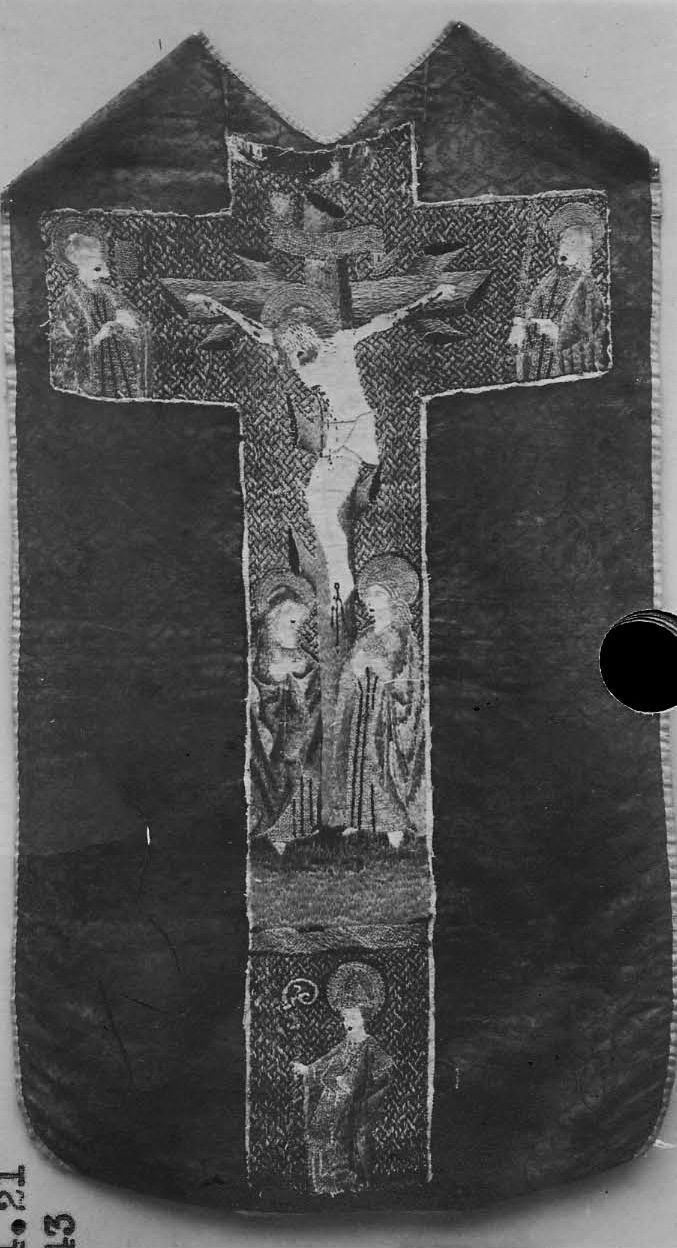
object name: chasuble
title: Chasuble with The Crucifixion, Holy Women and Saints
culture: german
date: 1601-1633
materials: silk, thread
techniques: brocade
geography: germany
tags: women,cross,saints